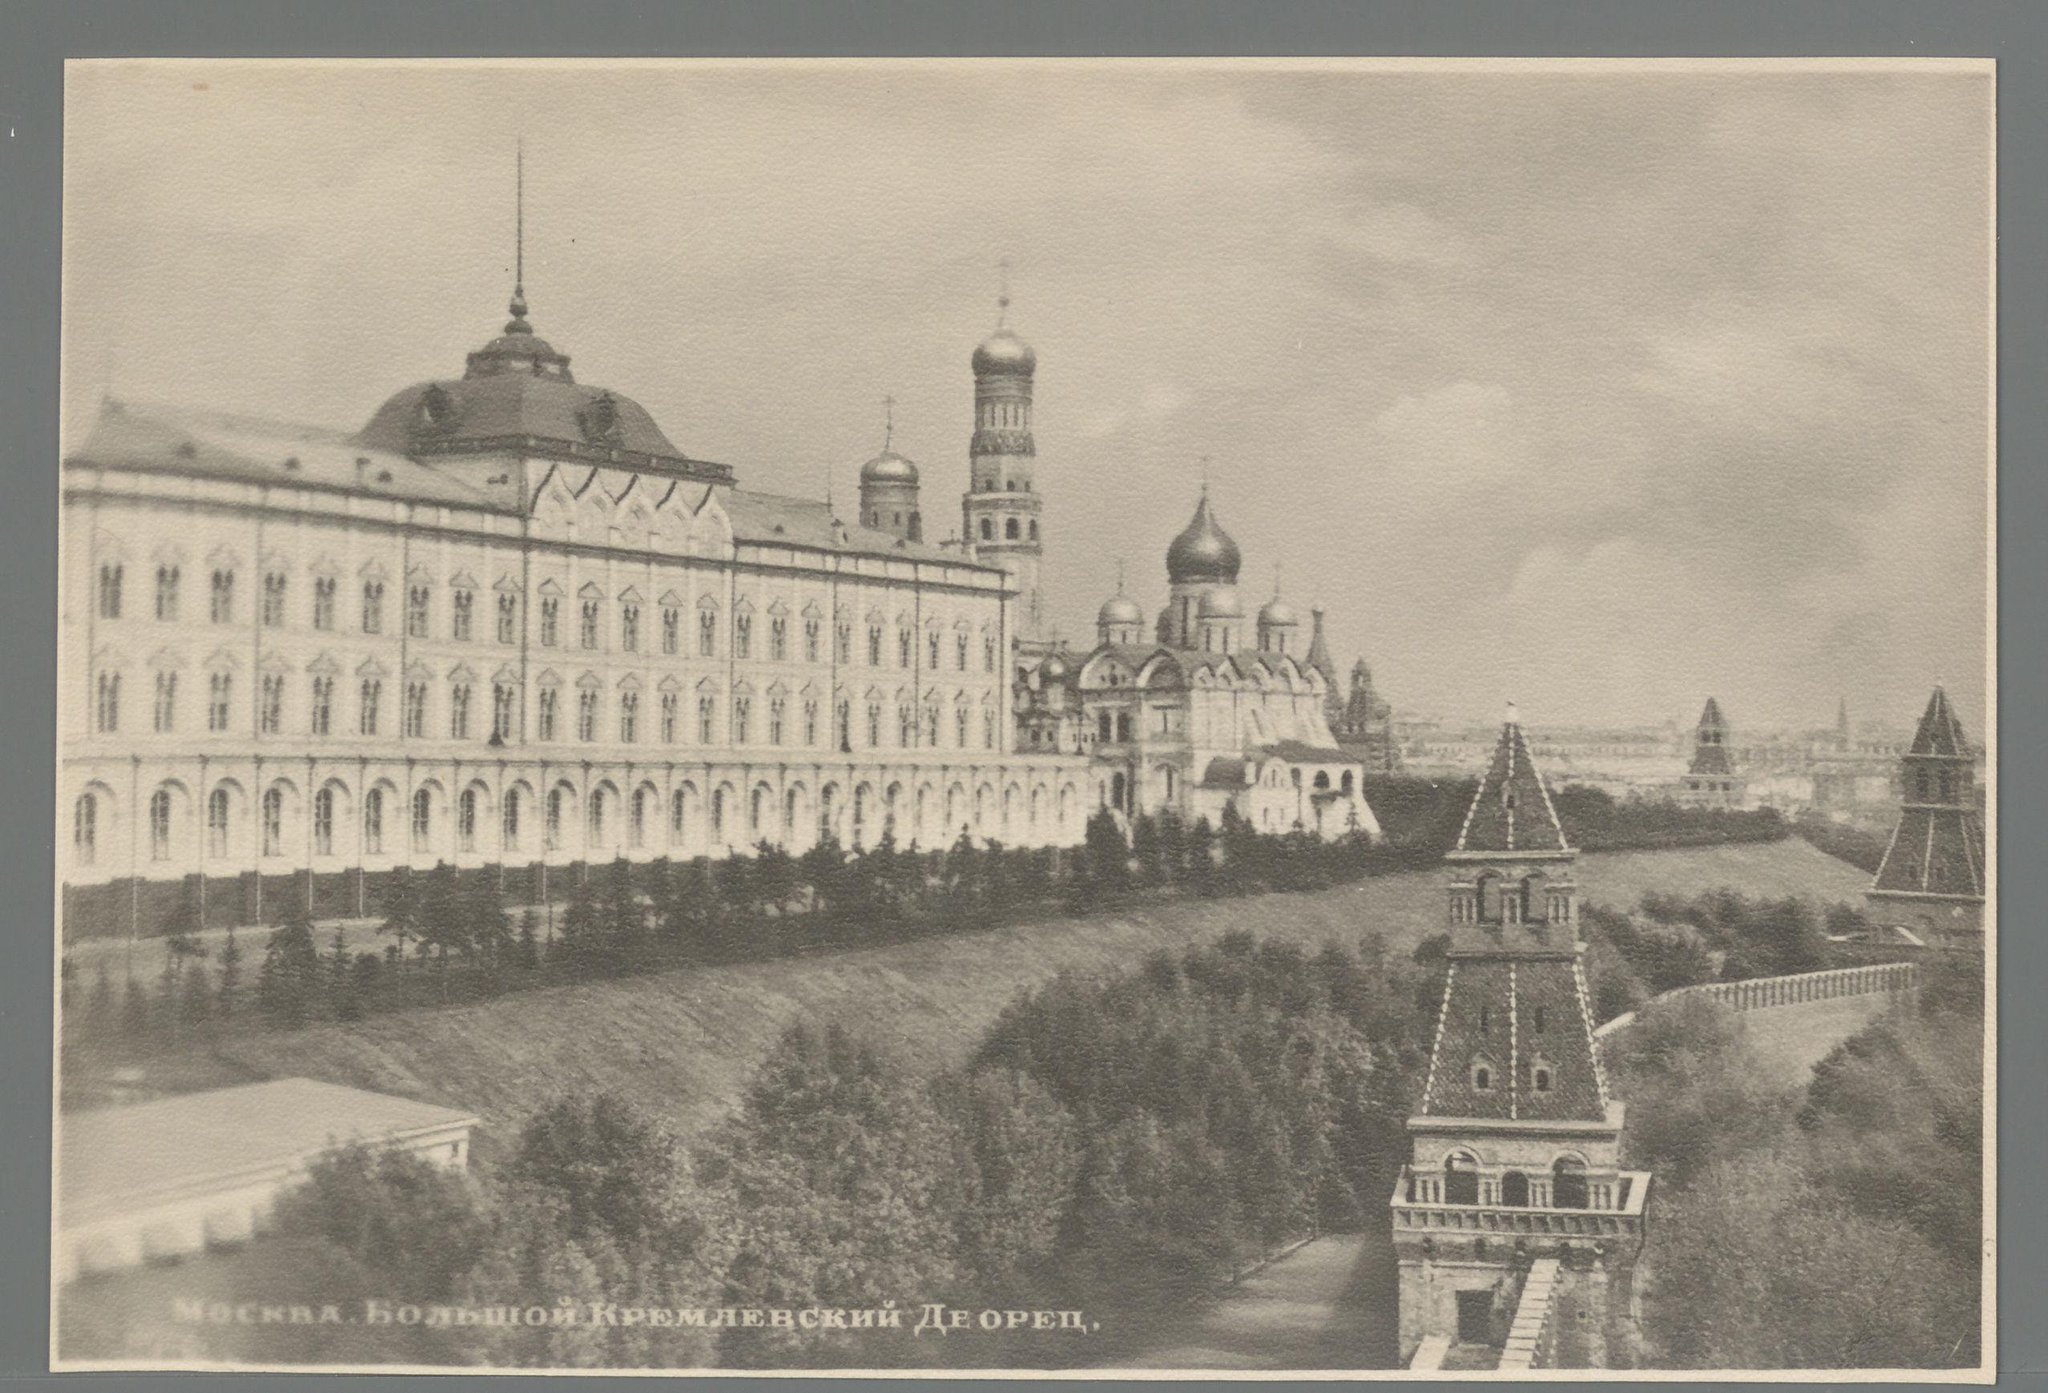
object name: photograph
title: Gezicht op het Groot Paleis in het Kremlin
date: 1954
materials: paper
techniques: gelatin silver print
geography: moscow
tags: palace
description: De titel op object staat in het Russisch.